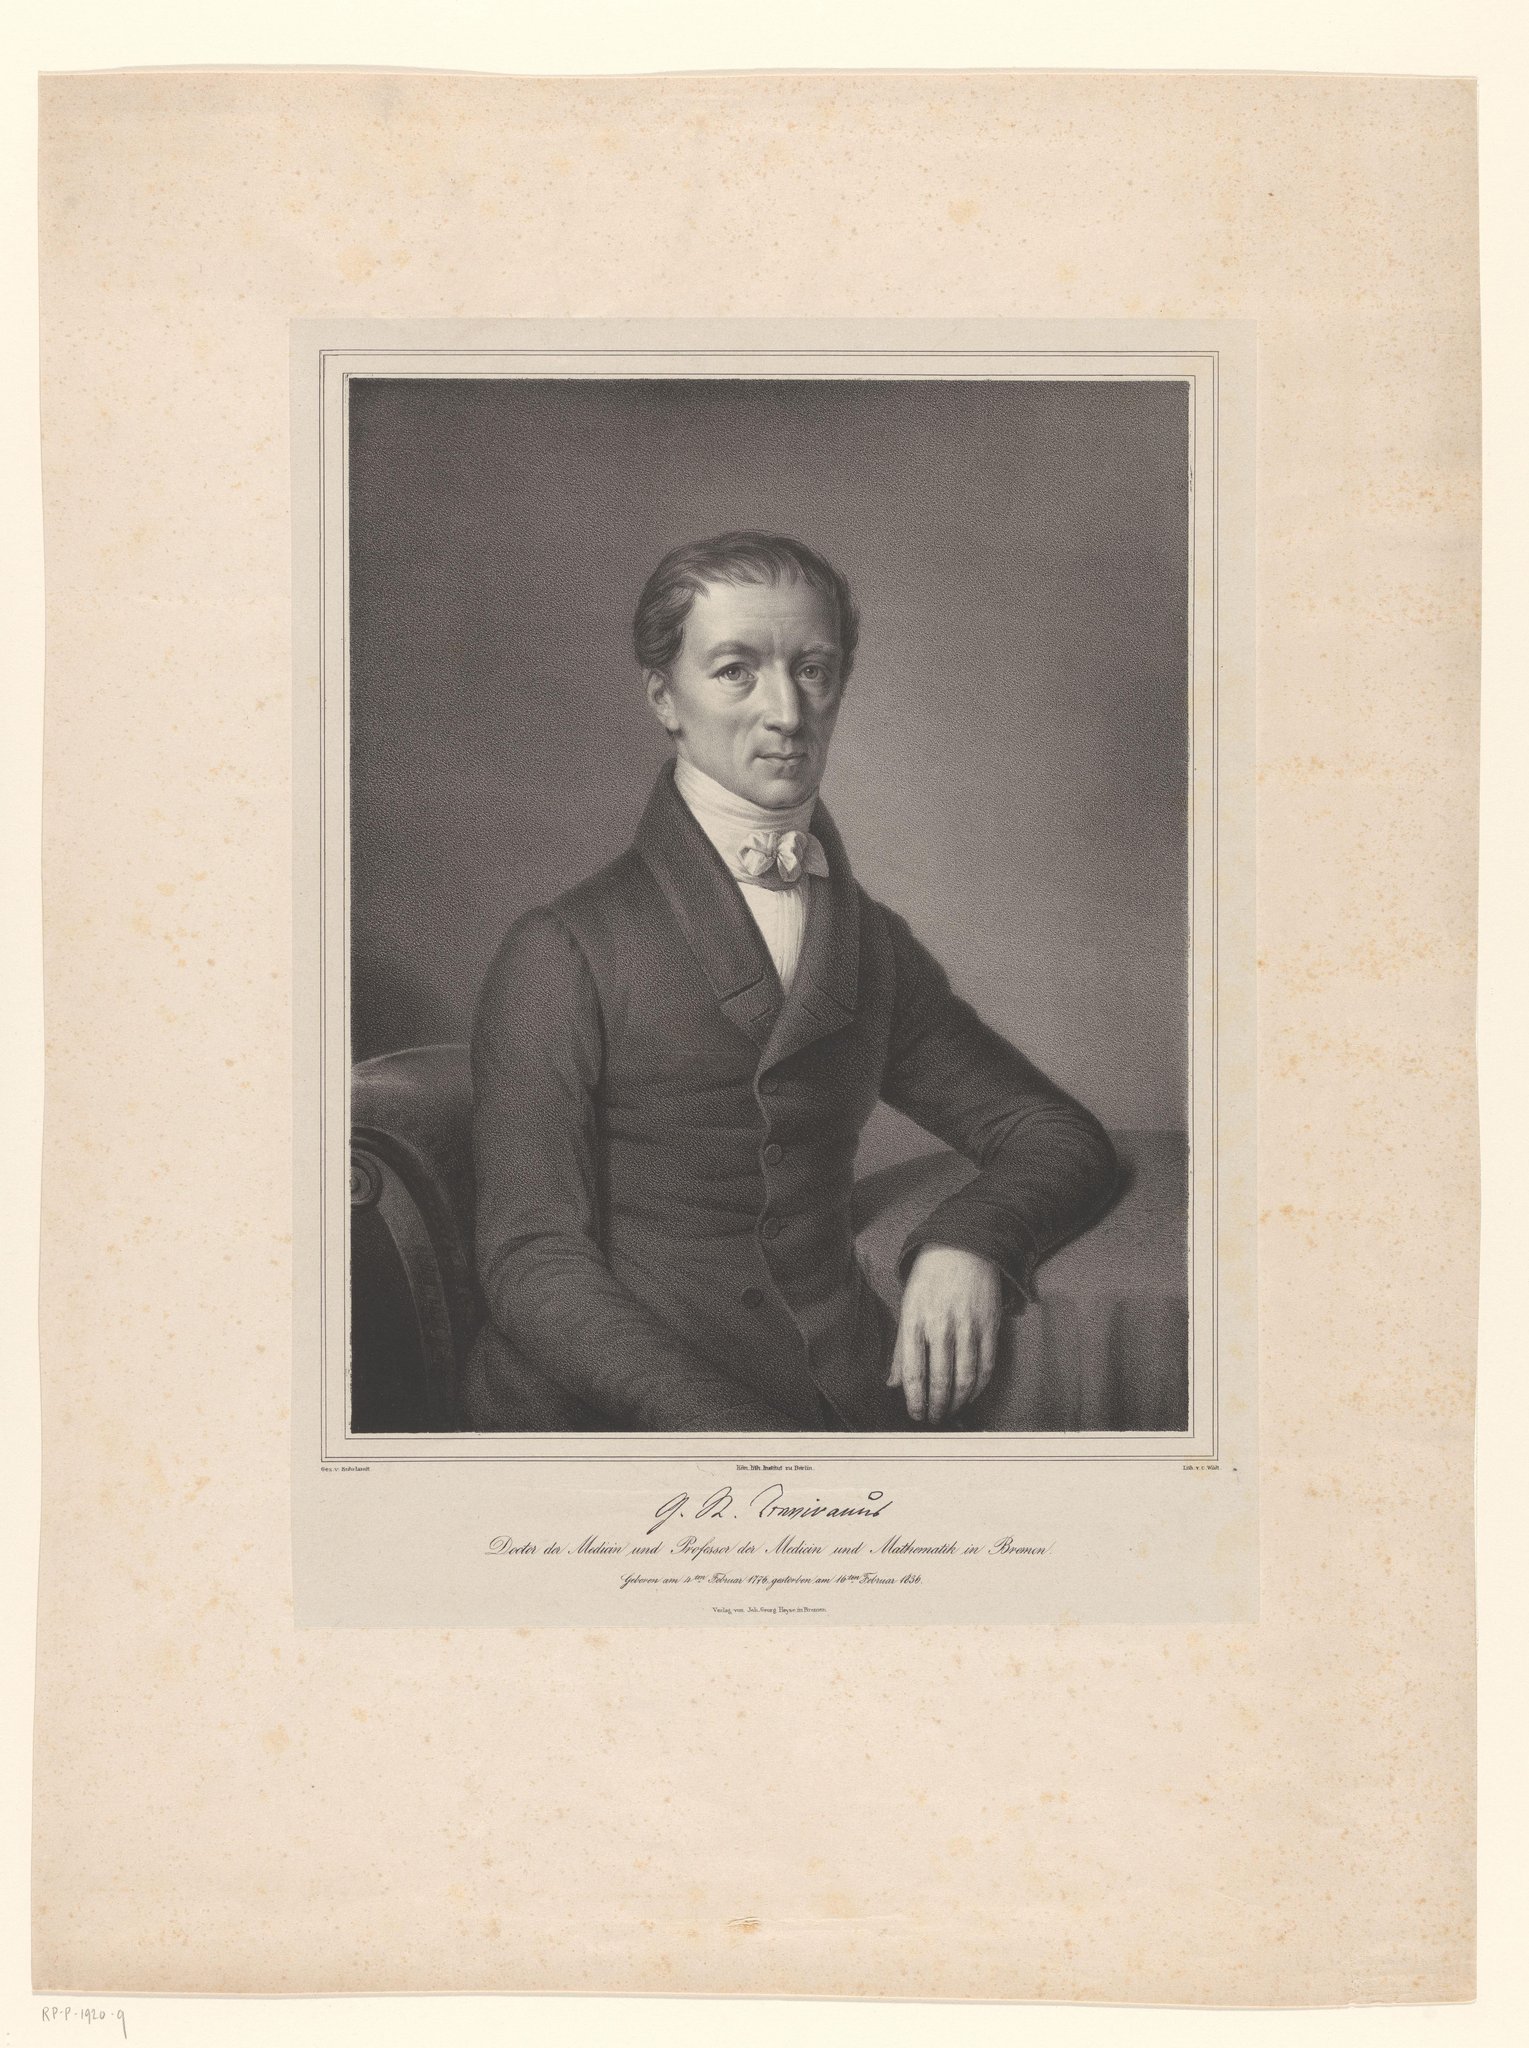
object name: print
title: Portret van Gottfried Reinhold Treviranus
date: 1836-1860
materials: paper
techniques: lithograph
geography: berlin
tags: adult man, historical persons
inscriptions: collector's mark: Lugt 2228